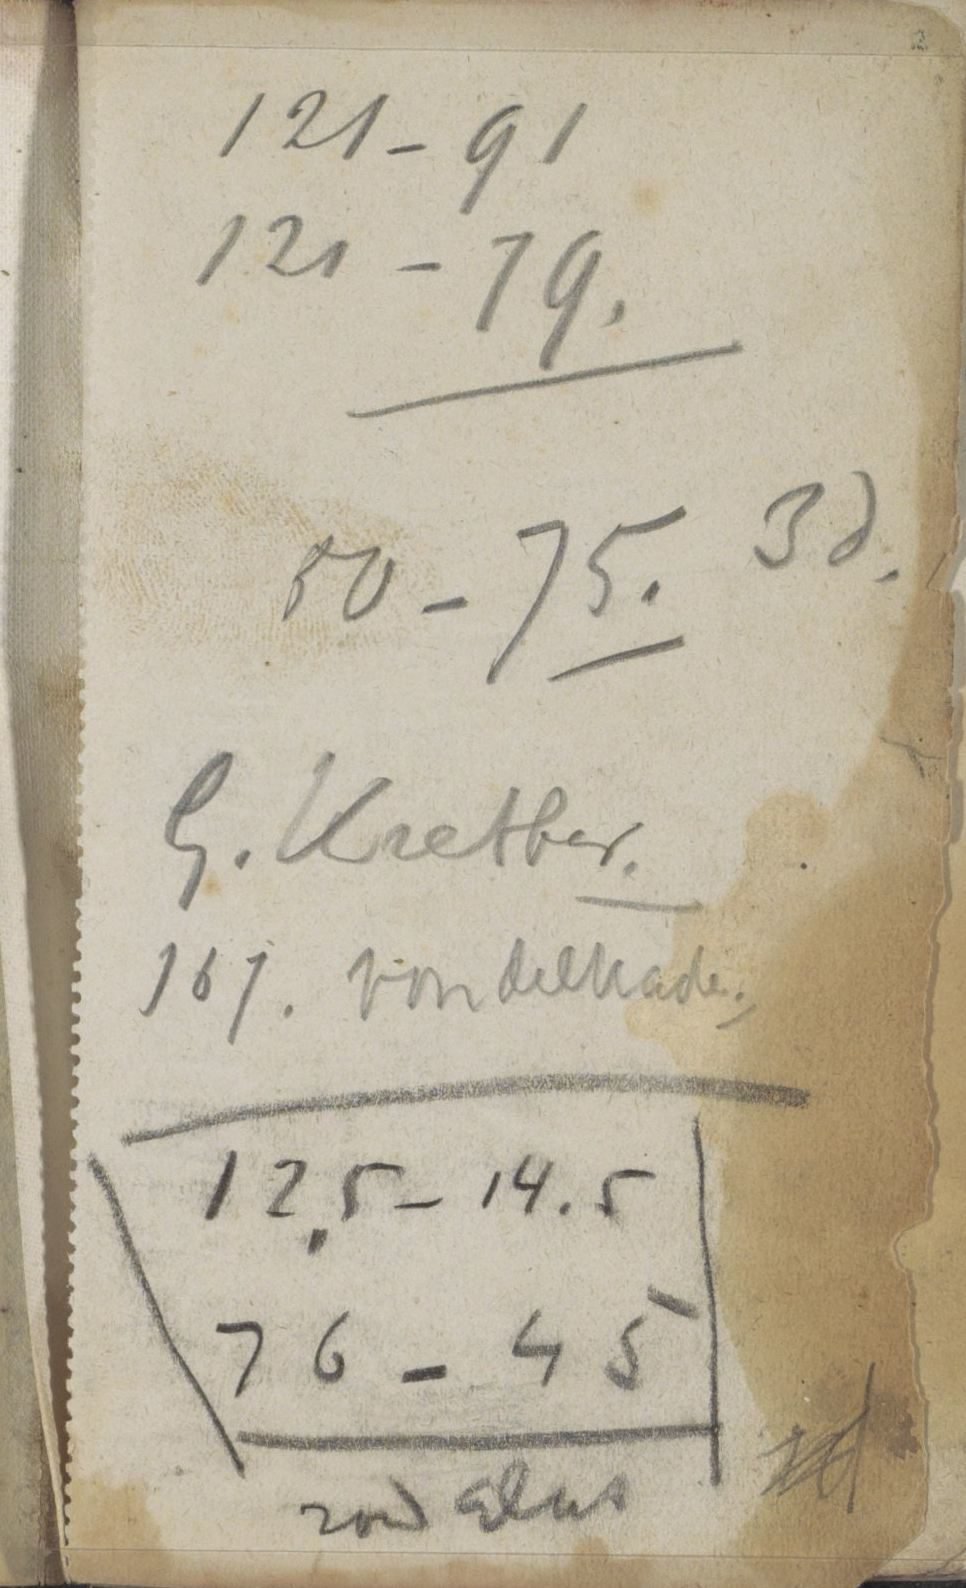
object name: sketchbook leaf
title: Annotaties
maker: george hendrik breitner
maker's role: draughtsman, painter, print maker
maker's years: 1857-1923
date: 1893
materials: chalk, paper, pencil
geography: amsterdam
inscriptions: annotation, annotation: ‘G. Kretber[?]/ 167. Vondelkade’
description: Aantekeningen. Pagina 2 uit een schetsboek met 22 bladen vervaardigd te Amsterdam.